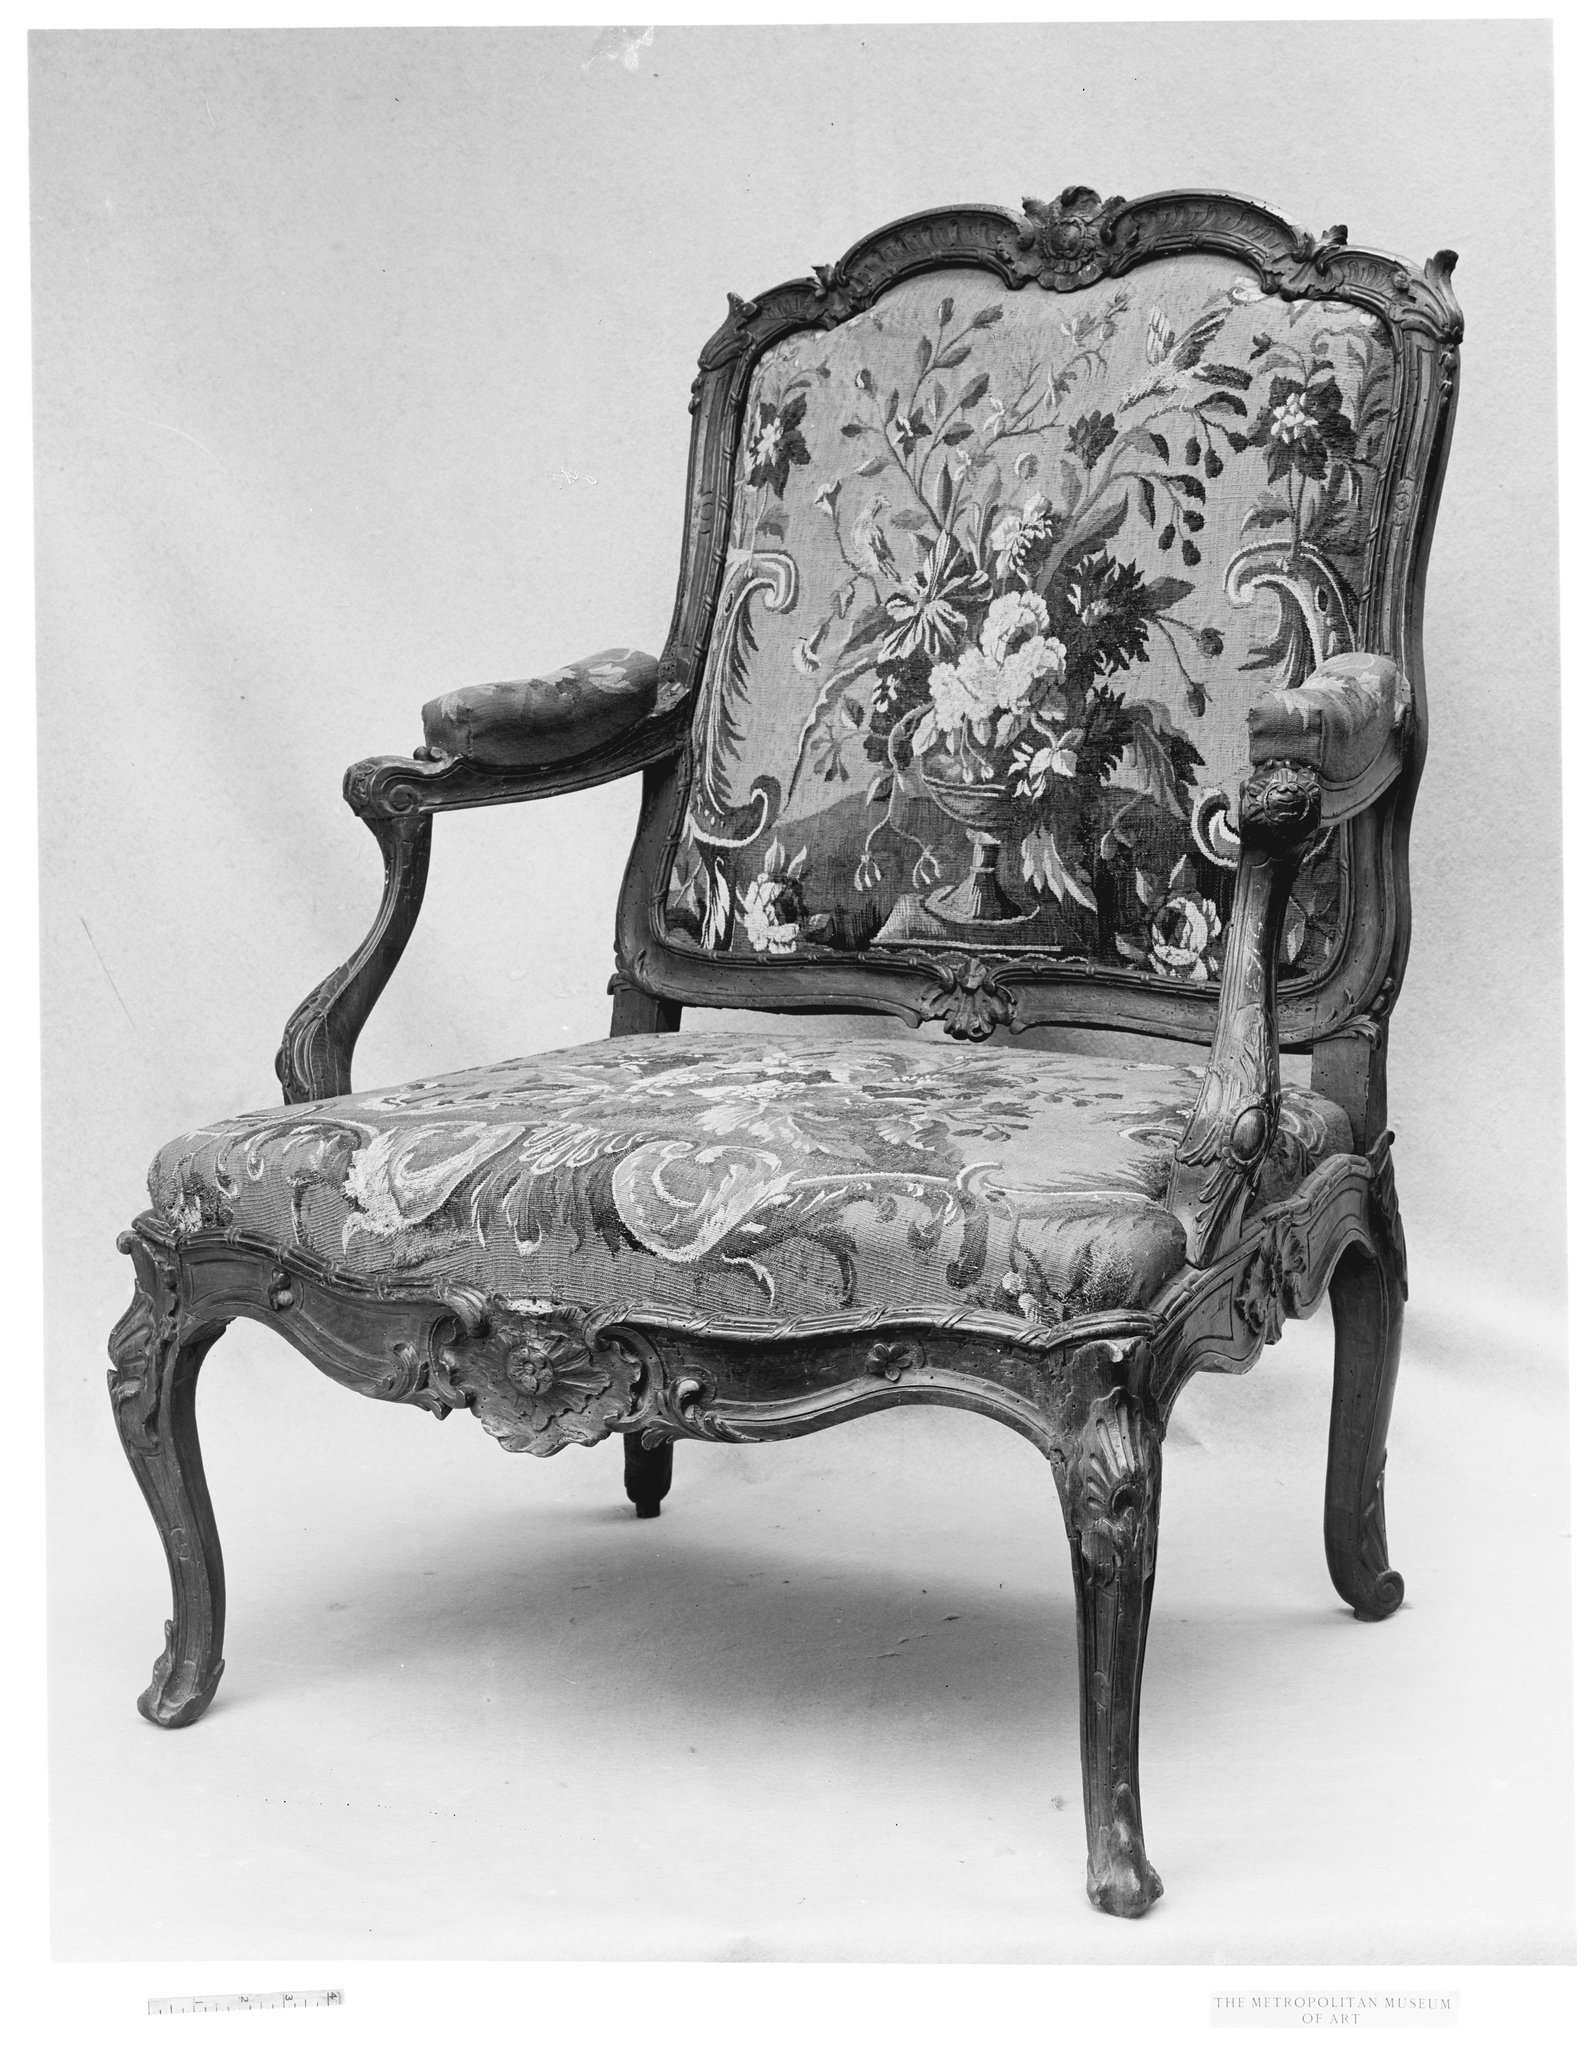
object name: armchair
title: Armchair (Fauteuil)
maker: aubusson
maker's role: factory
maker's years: 1665-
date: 1700-1735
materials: wood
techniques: carving, tapestry